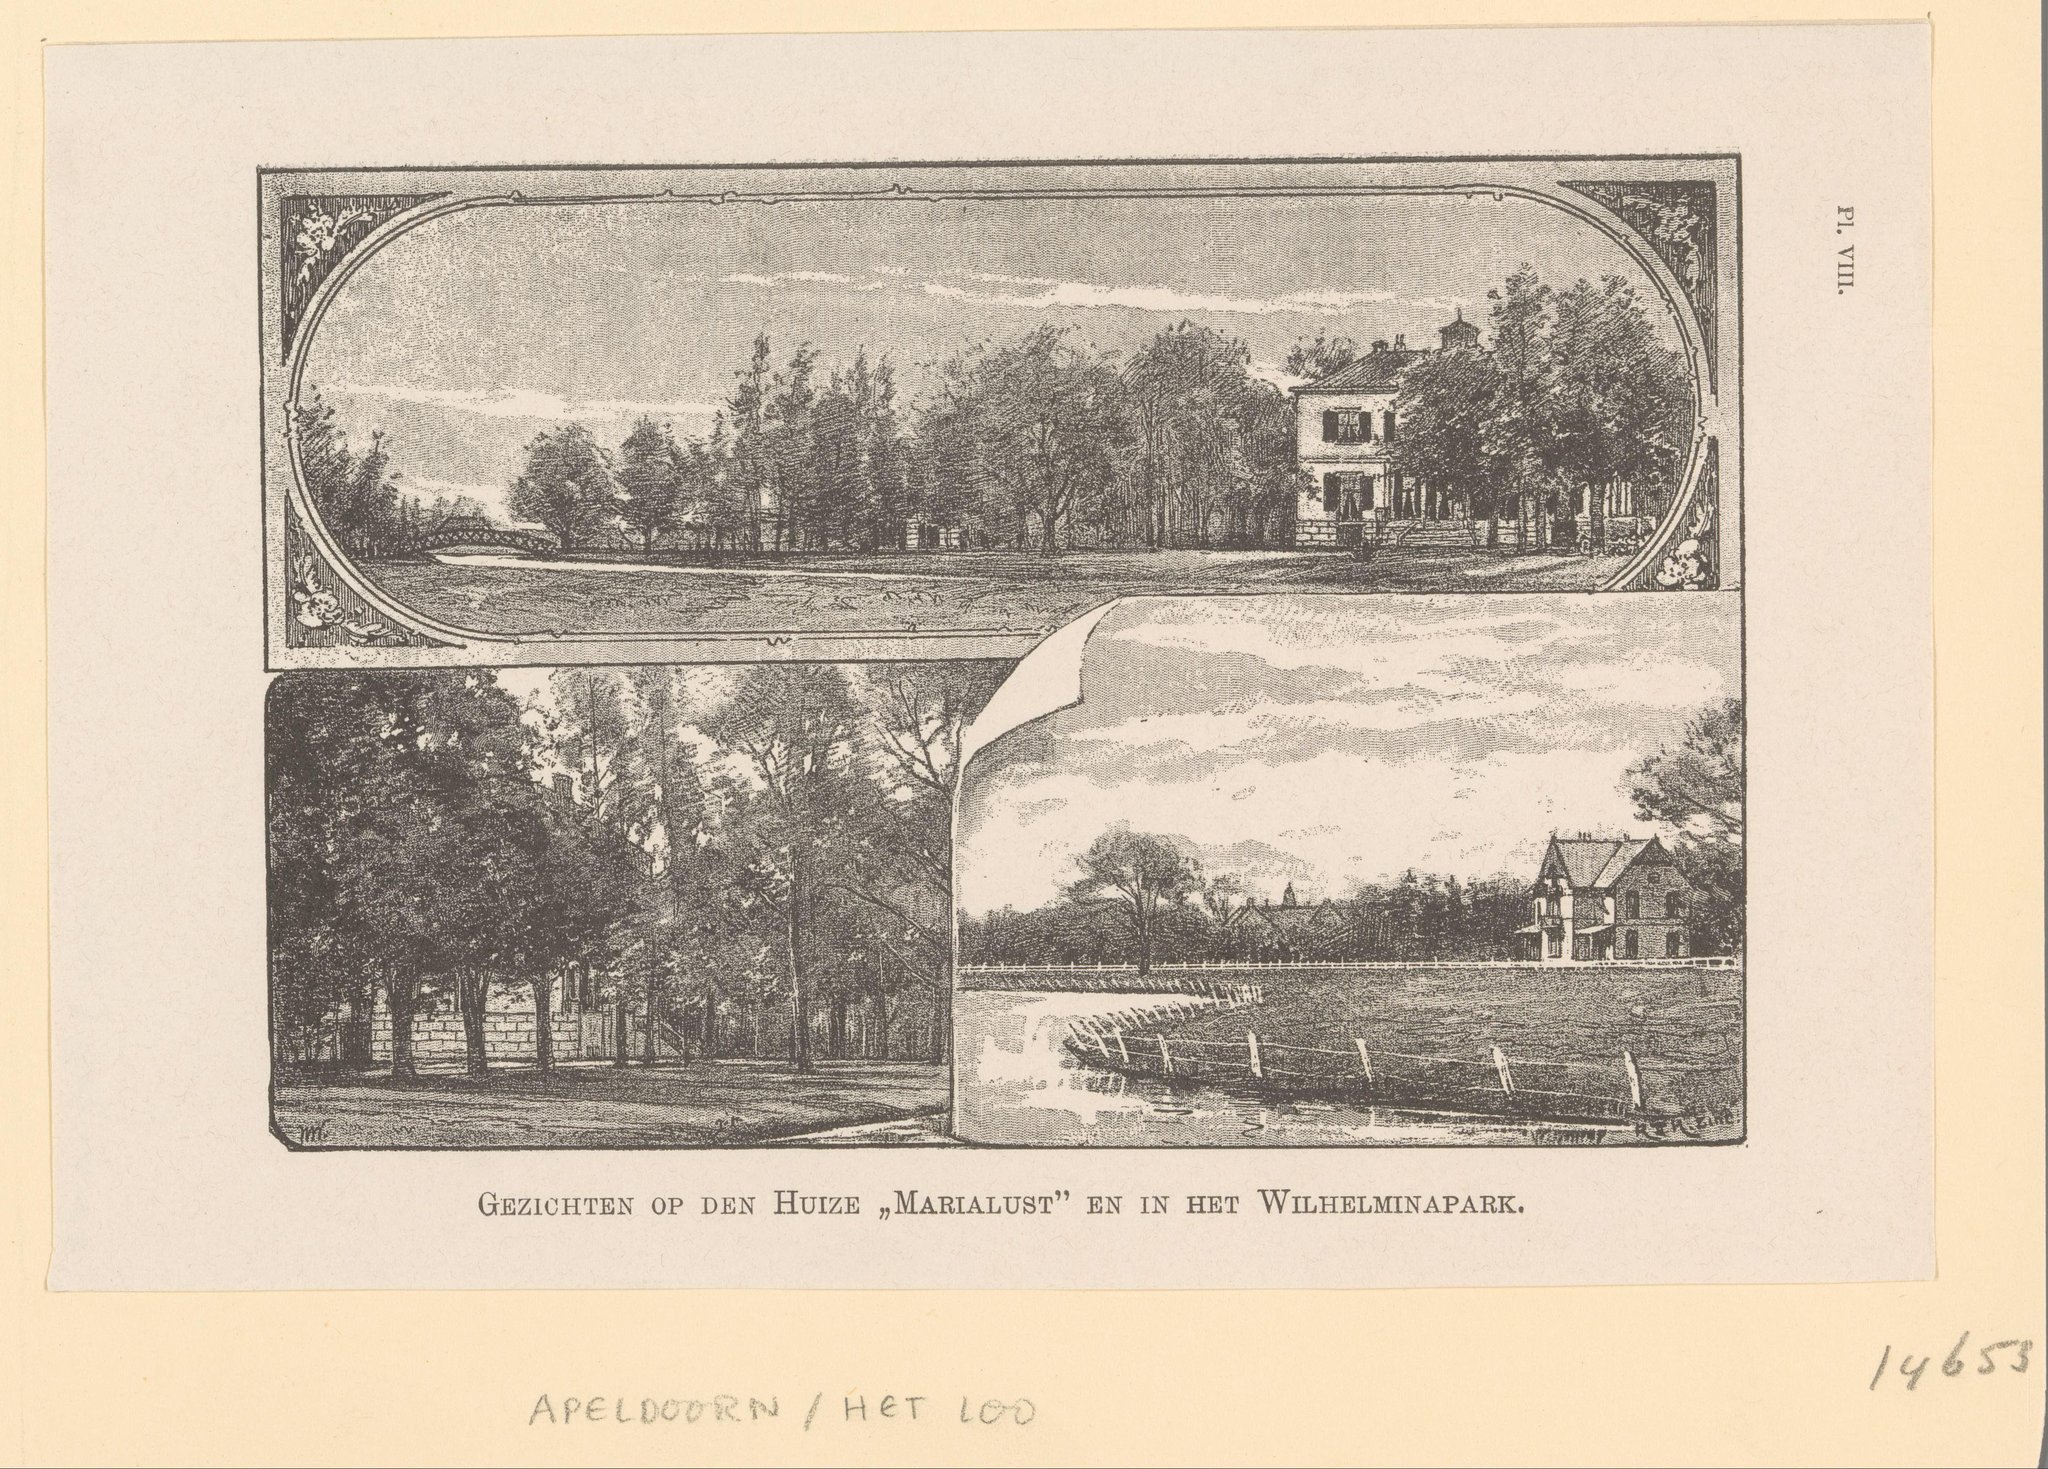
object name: photomechanical print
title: Gezicht op Marialust en het Wilhelminapark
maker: Anonymous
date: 1890-1900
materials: paper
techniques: autotype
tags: city-view, and landscape with man-made constructions, rural housing, e.g. country-house, villa, cottage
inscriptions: monogram, signature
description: Prent mogelijk uit: Gids voor Apeldoorn en omstreken. Apeldoorn: Vereeniging tot veraangenaming van het verblijf te Apeldoorn, [1891-1897].